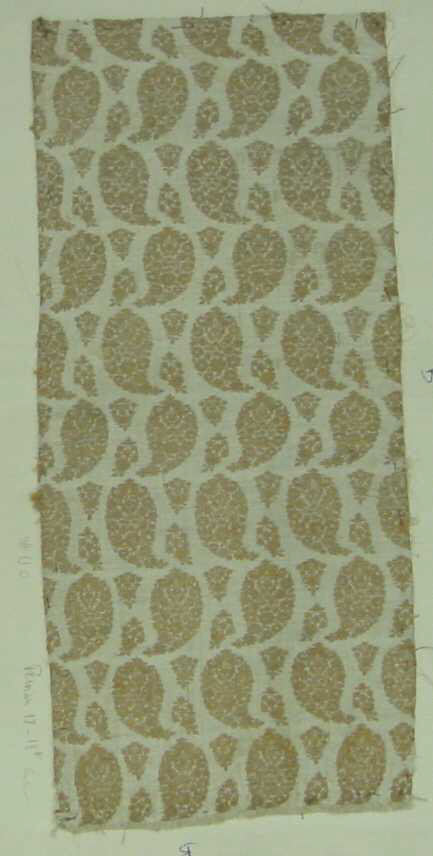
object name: textile fragment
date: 1601-1800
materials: metal thread, silk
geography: iran